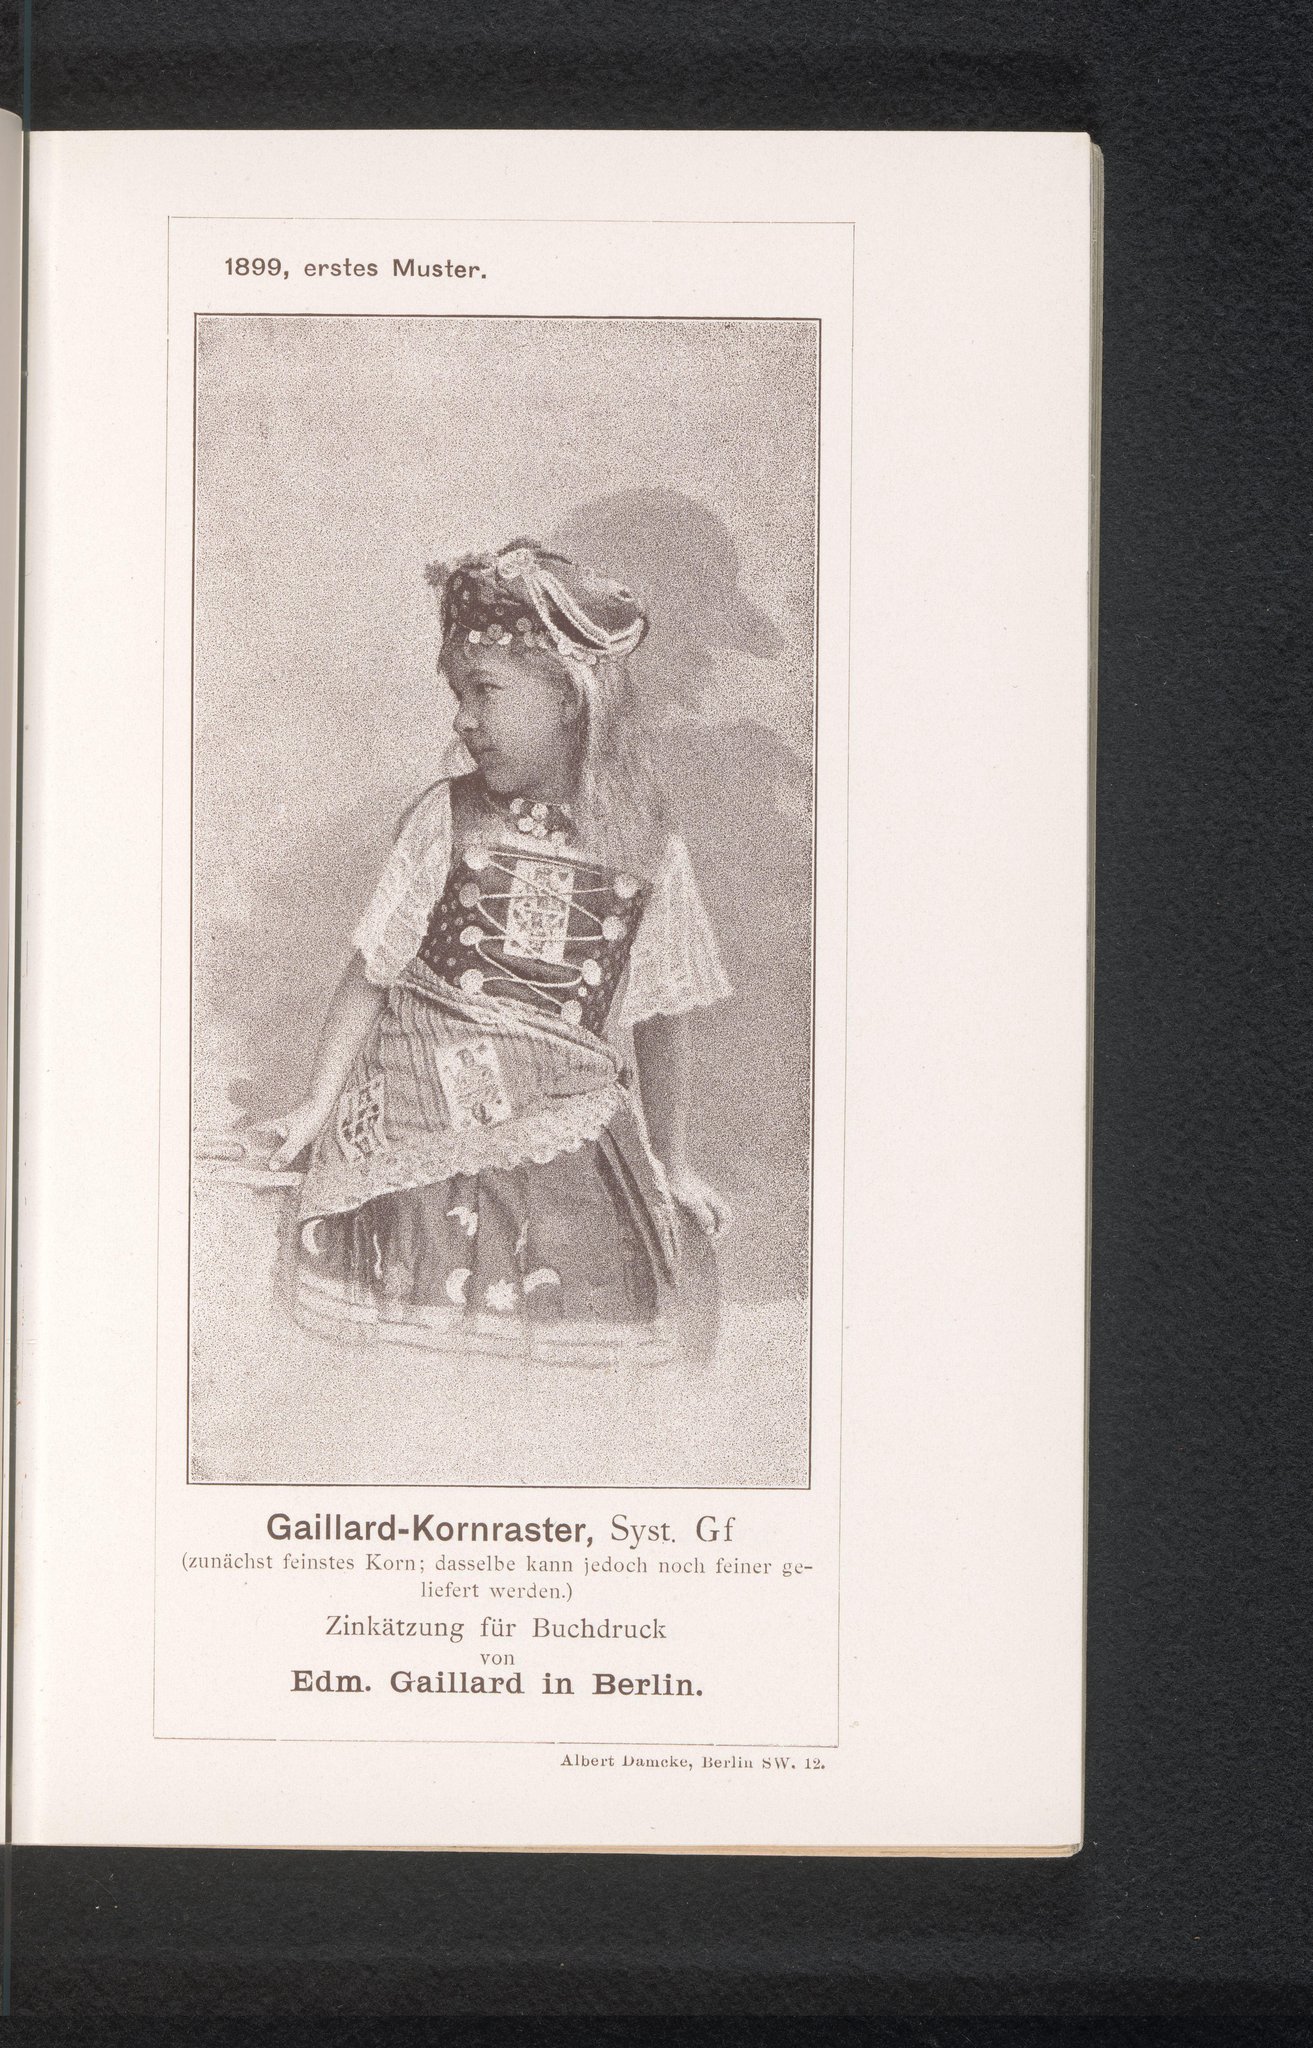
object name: page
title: Portret van een onbekend meisje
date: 1894-1899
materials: paper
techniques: collo-autotype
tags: historical persons, girl (child between toddler and youth)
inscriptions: inscription: ‘1899, erstes Muster./ Gaillard-Kornraster, Syst. Gf (zunächst feinest Korn; dasselbe kann jedoch noch feiner geliefert werden)/ Zinkätzung für Buchdruck (...)’